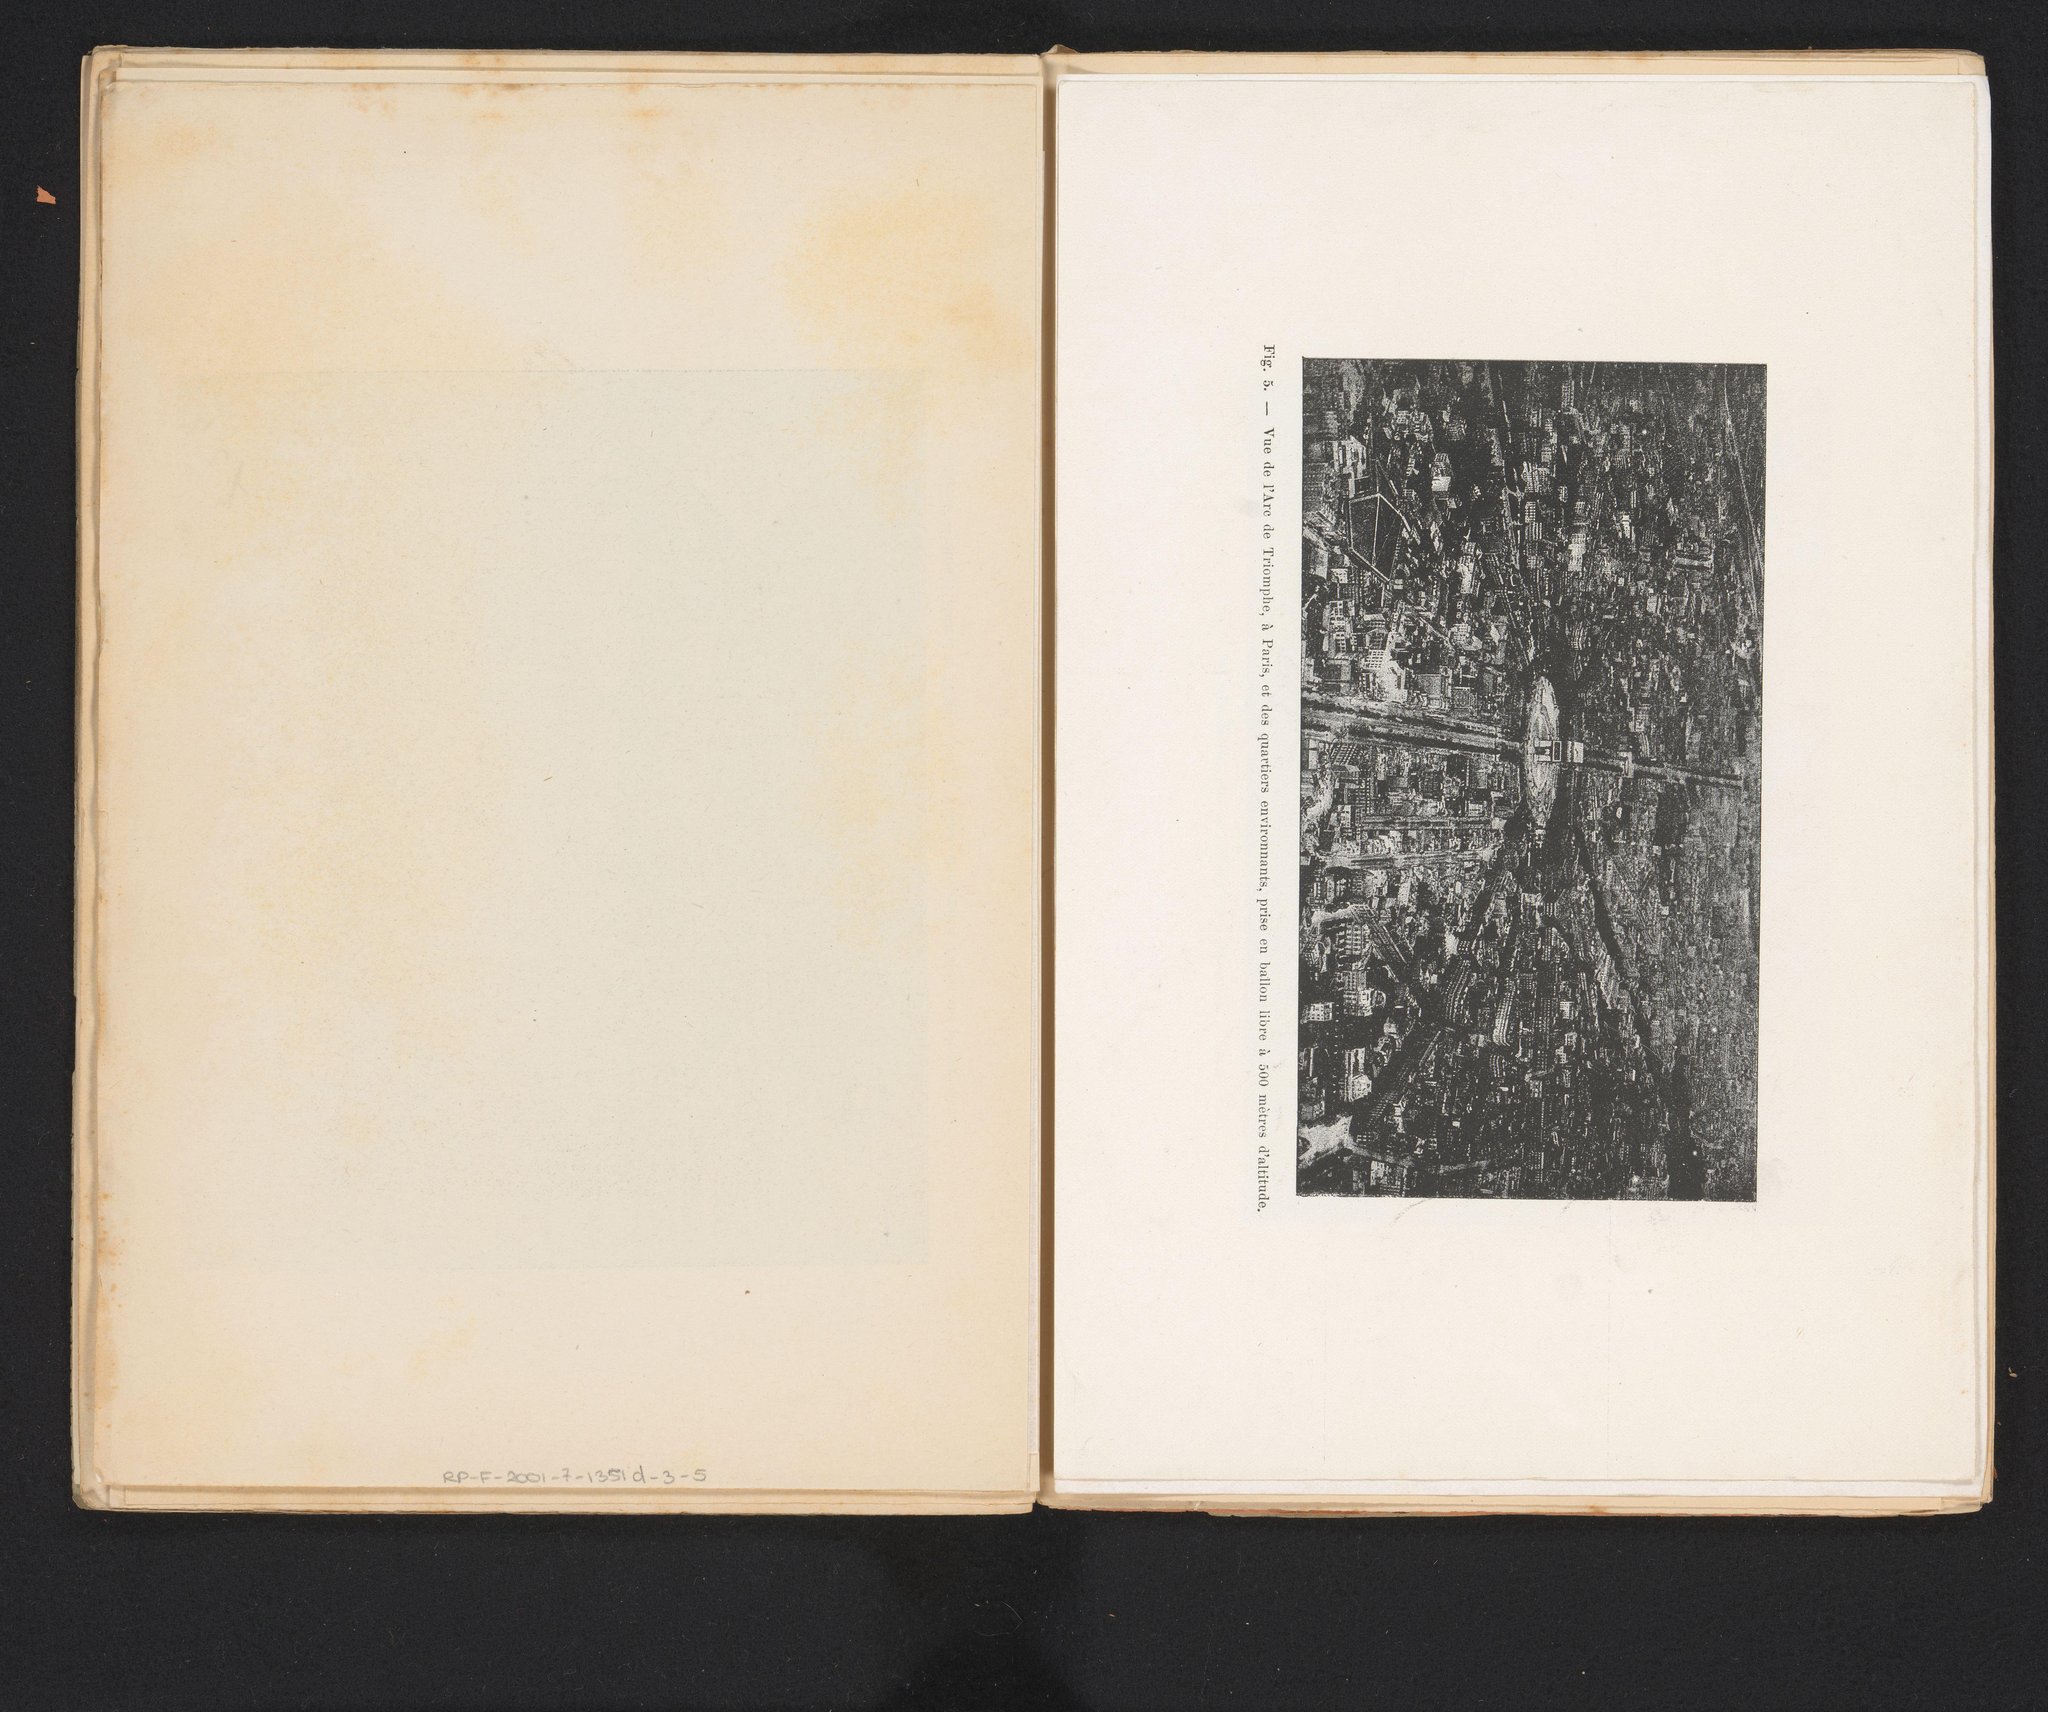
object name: page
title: Bovenaanzicht van Parijs, met in het midden de Arc de Triomphe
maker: Anonymous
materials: paper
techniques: collo-autotype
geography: paris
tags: prospect of city, town panorama, silhouette of city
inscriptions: inscription: ‘Fig. 5. - Vue de l'Arc de Triomphe, à paris, et des quartiers environnants, prise en ballon libre à 500 mètres d'altitude.’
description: Prent op plaat los in boek tussen pagina 134 en 135.